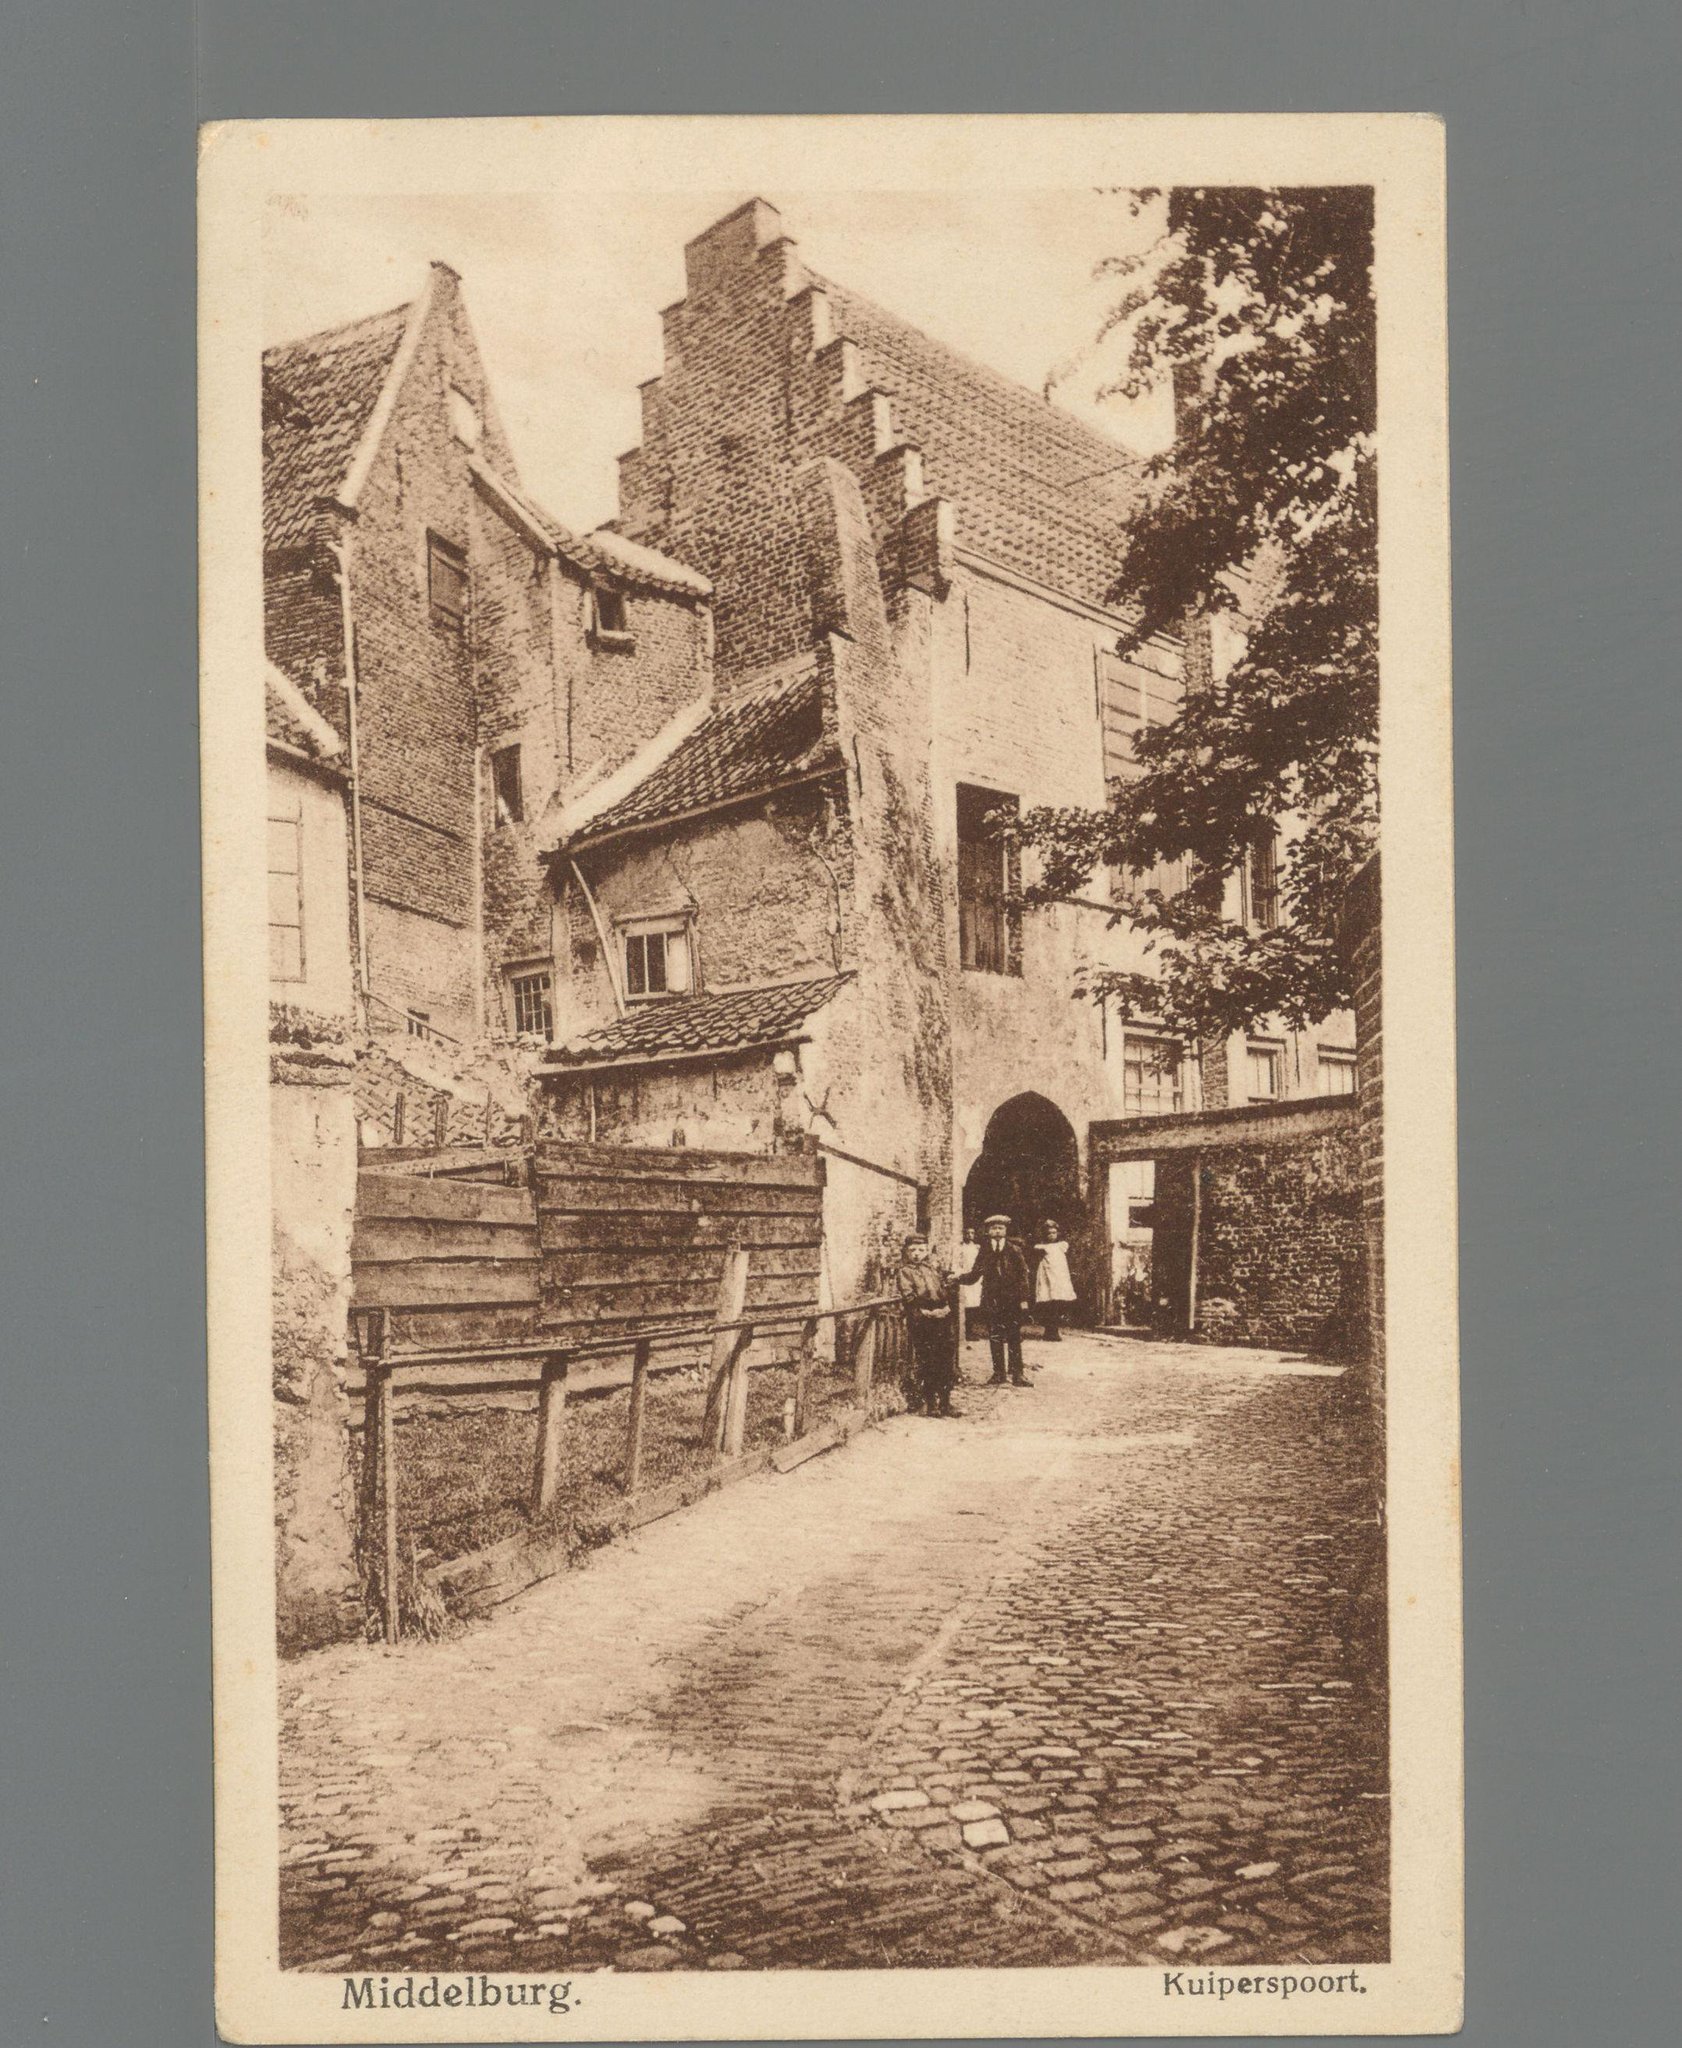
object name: ansichtkaart, prentbriefkaart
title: J.H. Schaefer's Fotoplatin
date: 1913-1925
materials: cardboard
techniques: photograph, writing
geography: amsterdam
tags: city-gate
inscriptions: postage stamp